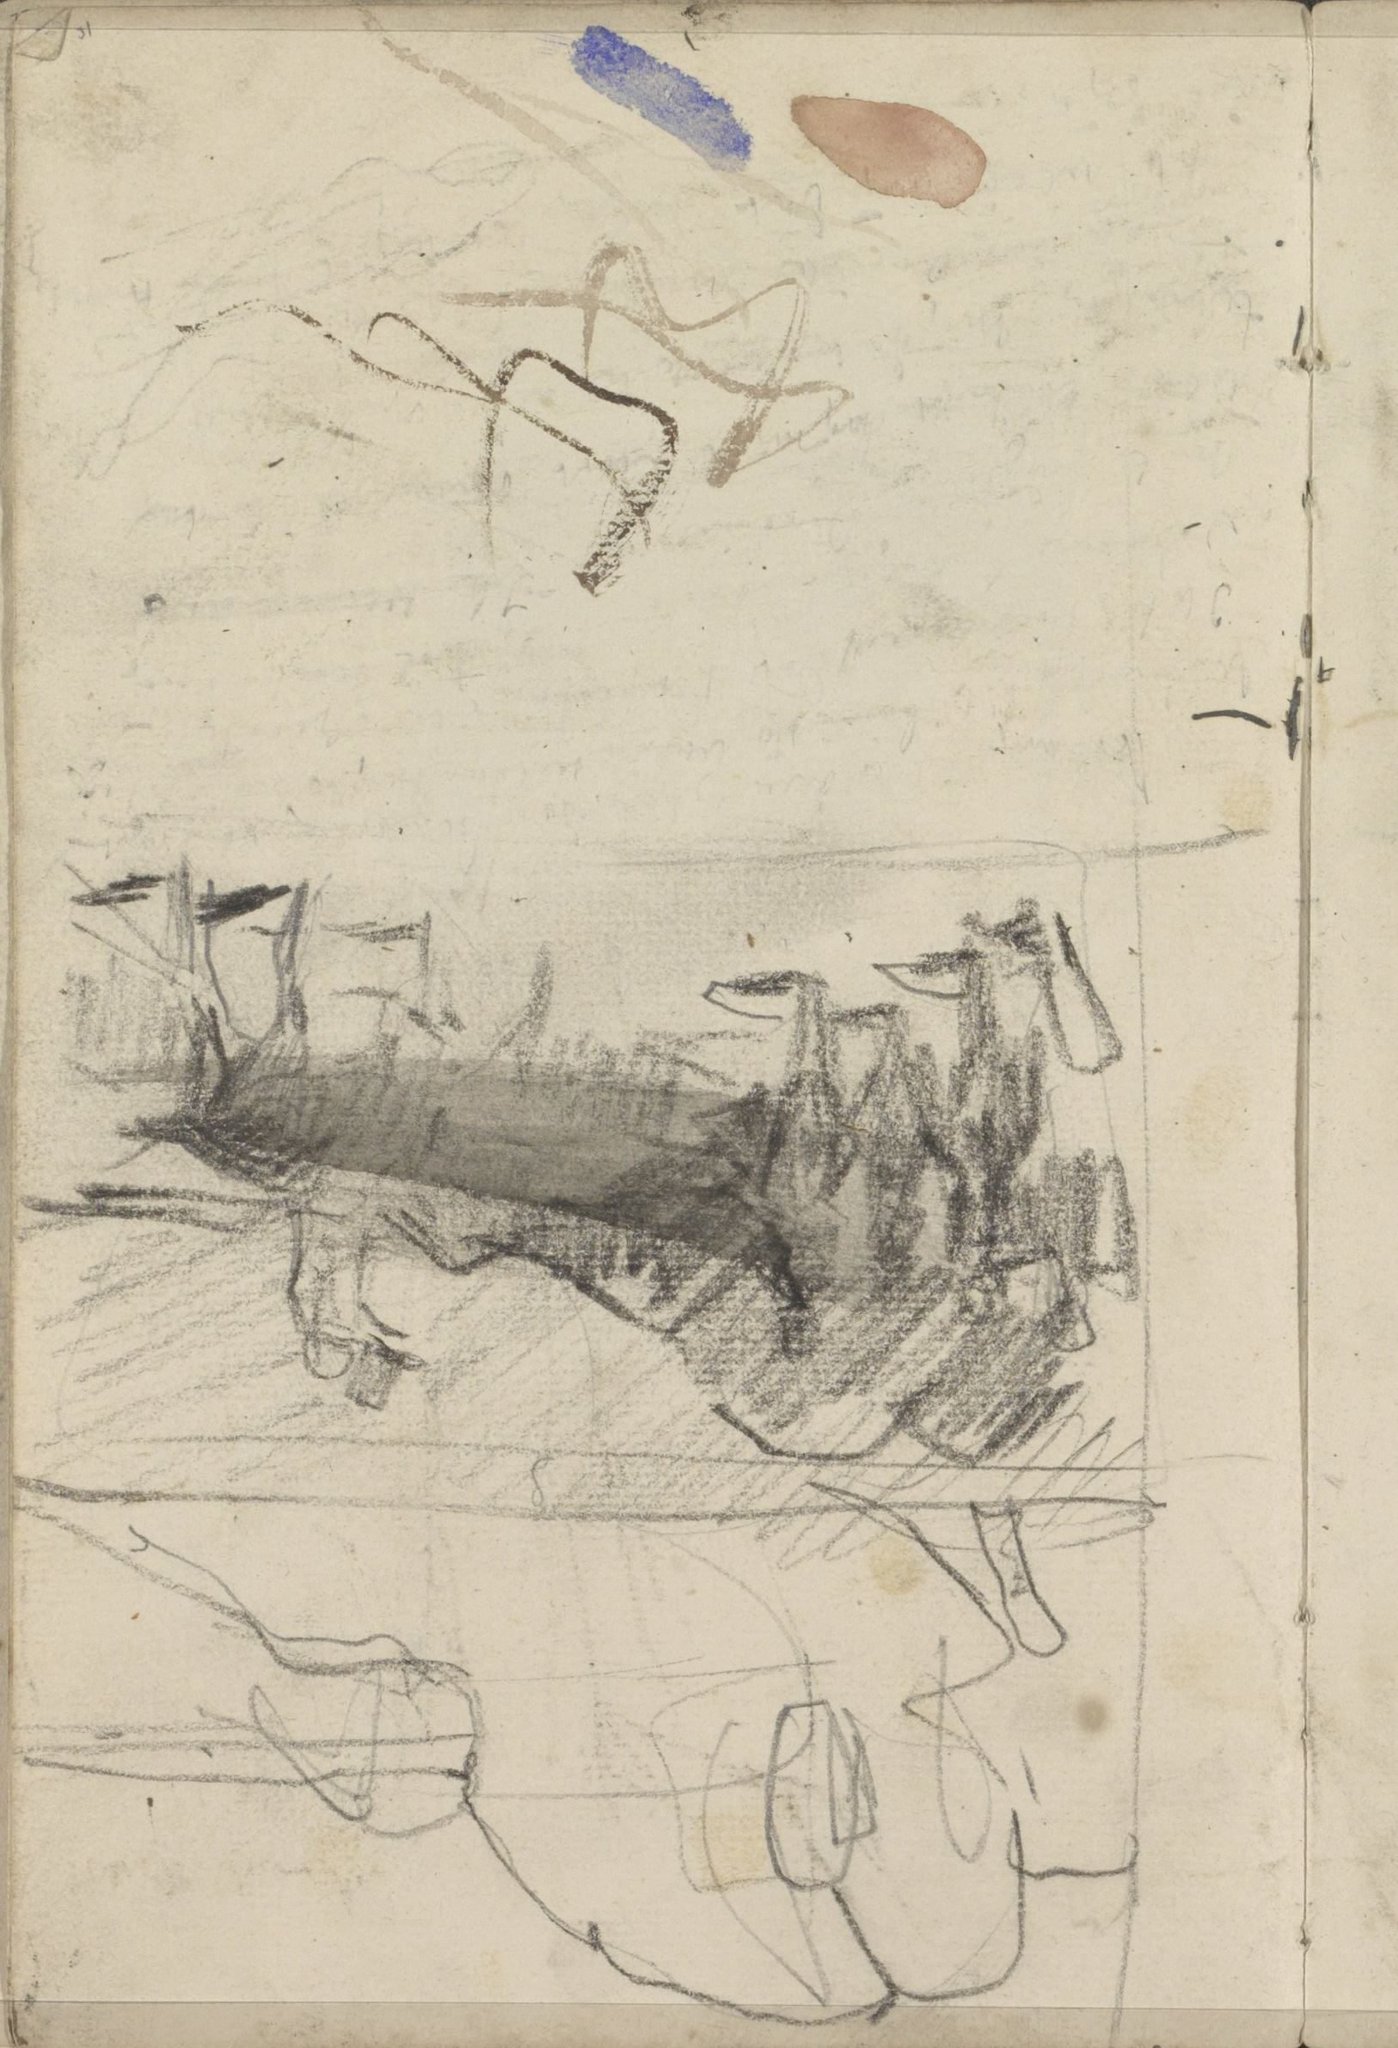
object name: sketchbook leaf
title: Ruiters, mogelijk soldaten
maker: george hendrik breitner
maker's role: draughtsman, painter, print maker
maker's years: 1857-1923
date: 1881-1883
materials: chalk, paper, pencil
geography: the hague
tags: riding a horse, ass, or mule; rider, horseman, division of armed forces (+ land forces)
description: Pagina 31 uit een schetsboek met 19 bladen.